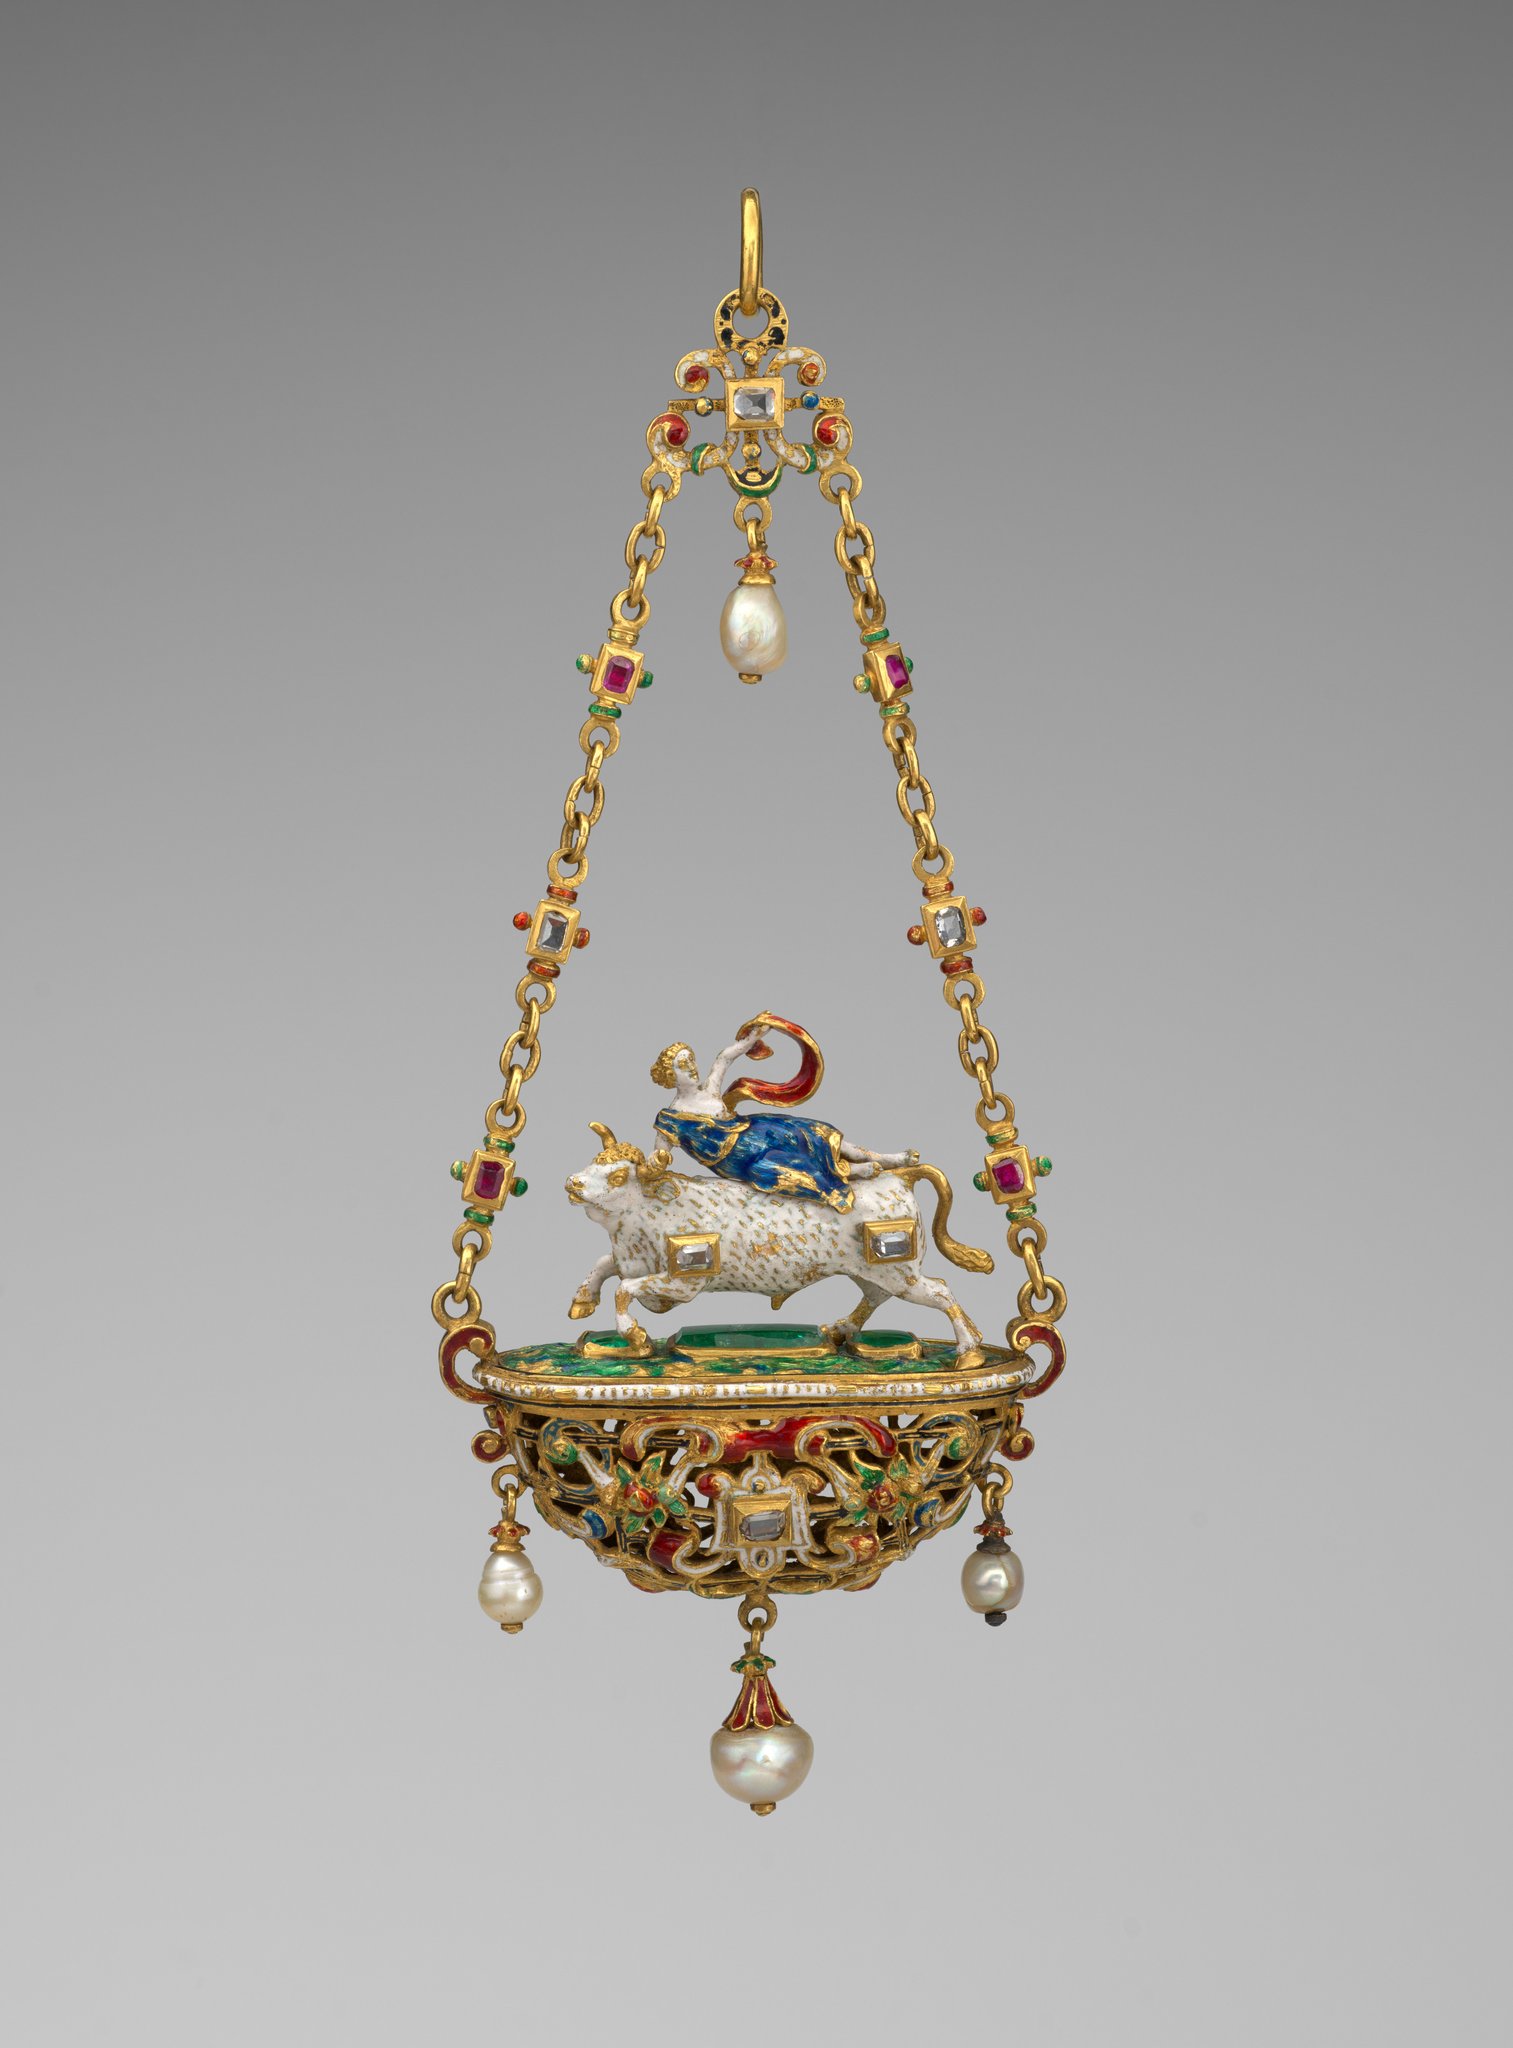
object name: pendant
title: Rape of Europa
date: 1801-1900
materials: diamond, gemstone, enamel, gold, pearl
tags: animals,europa,snakes